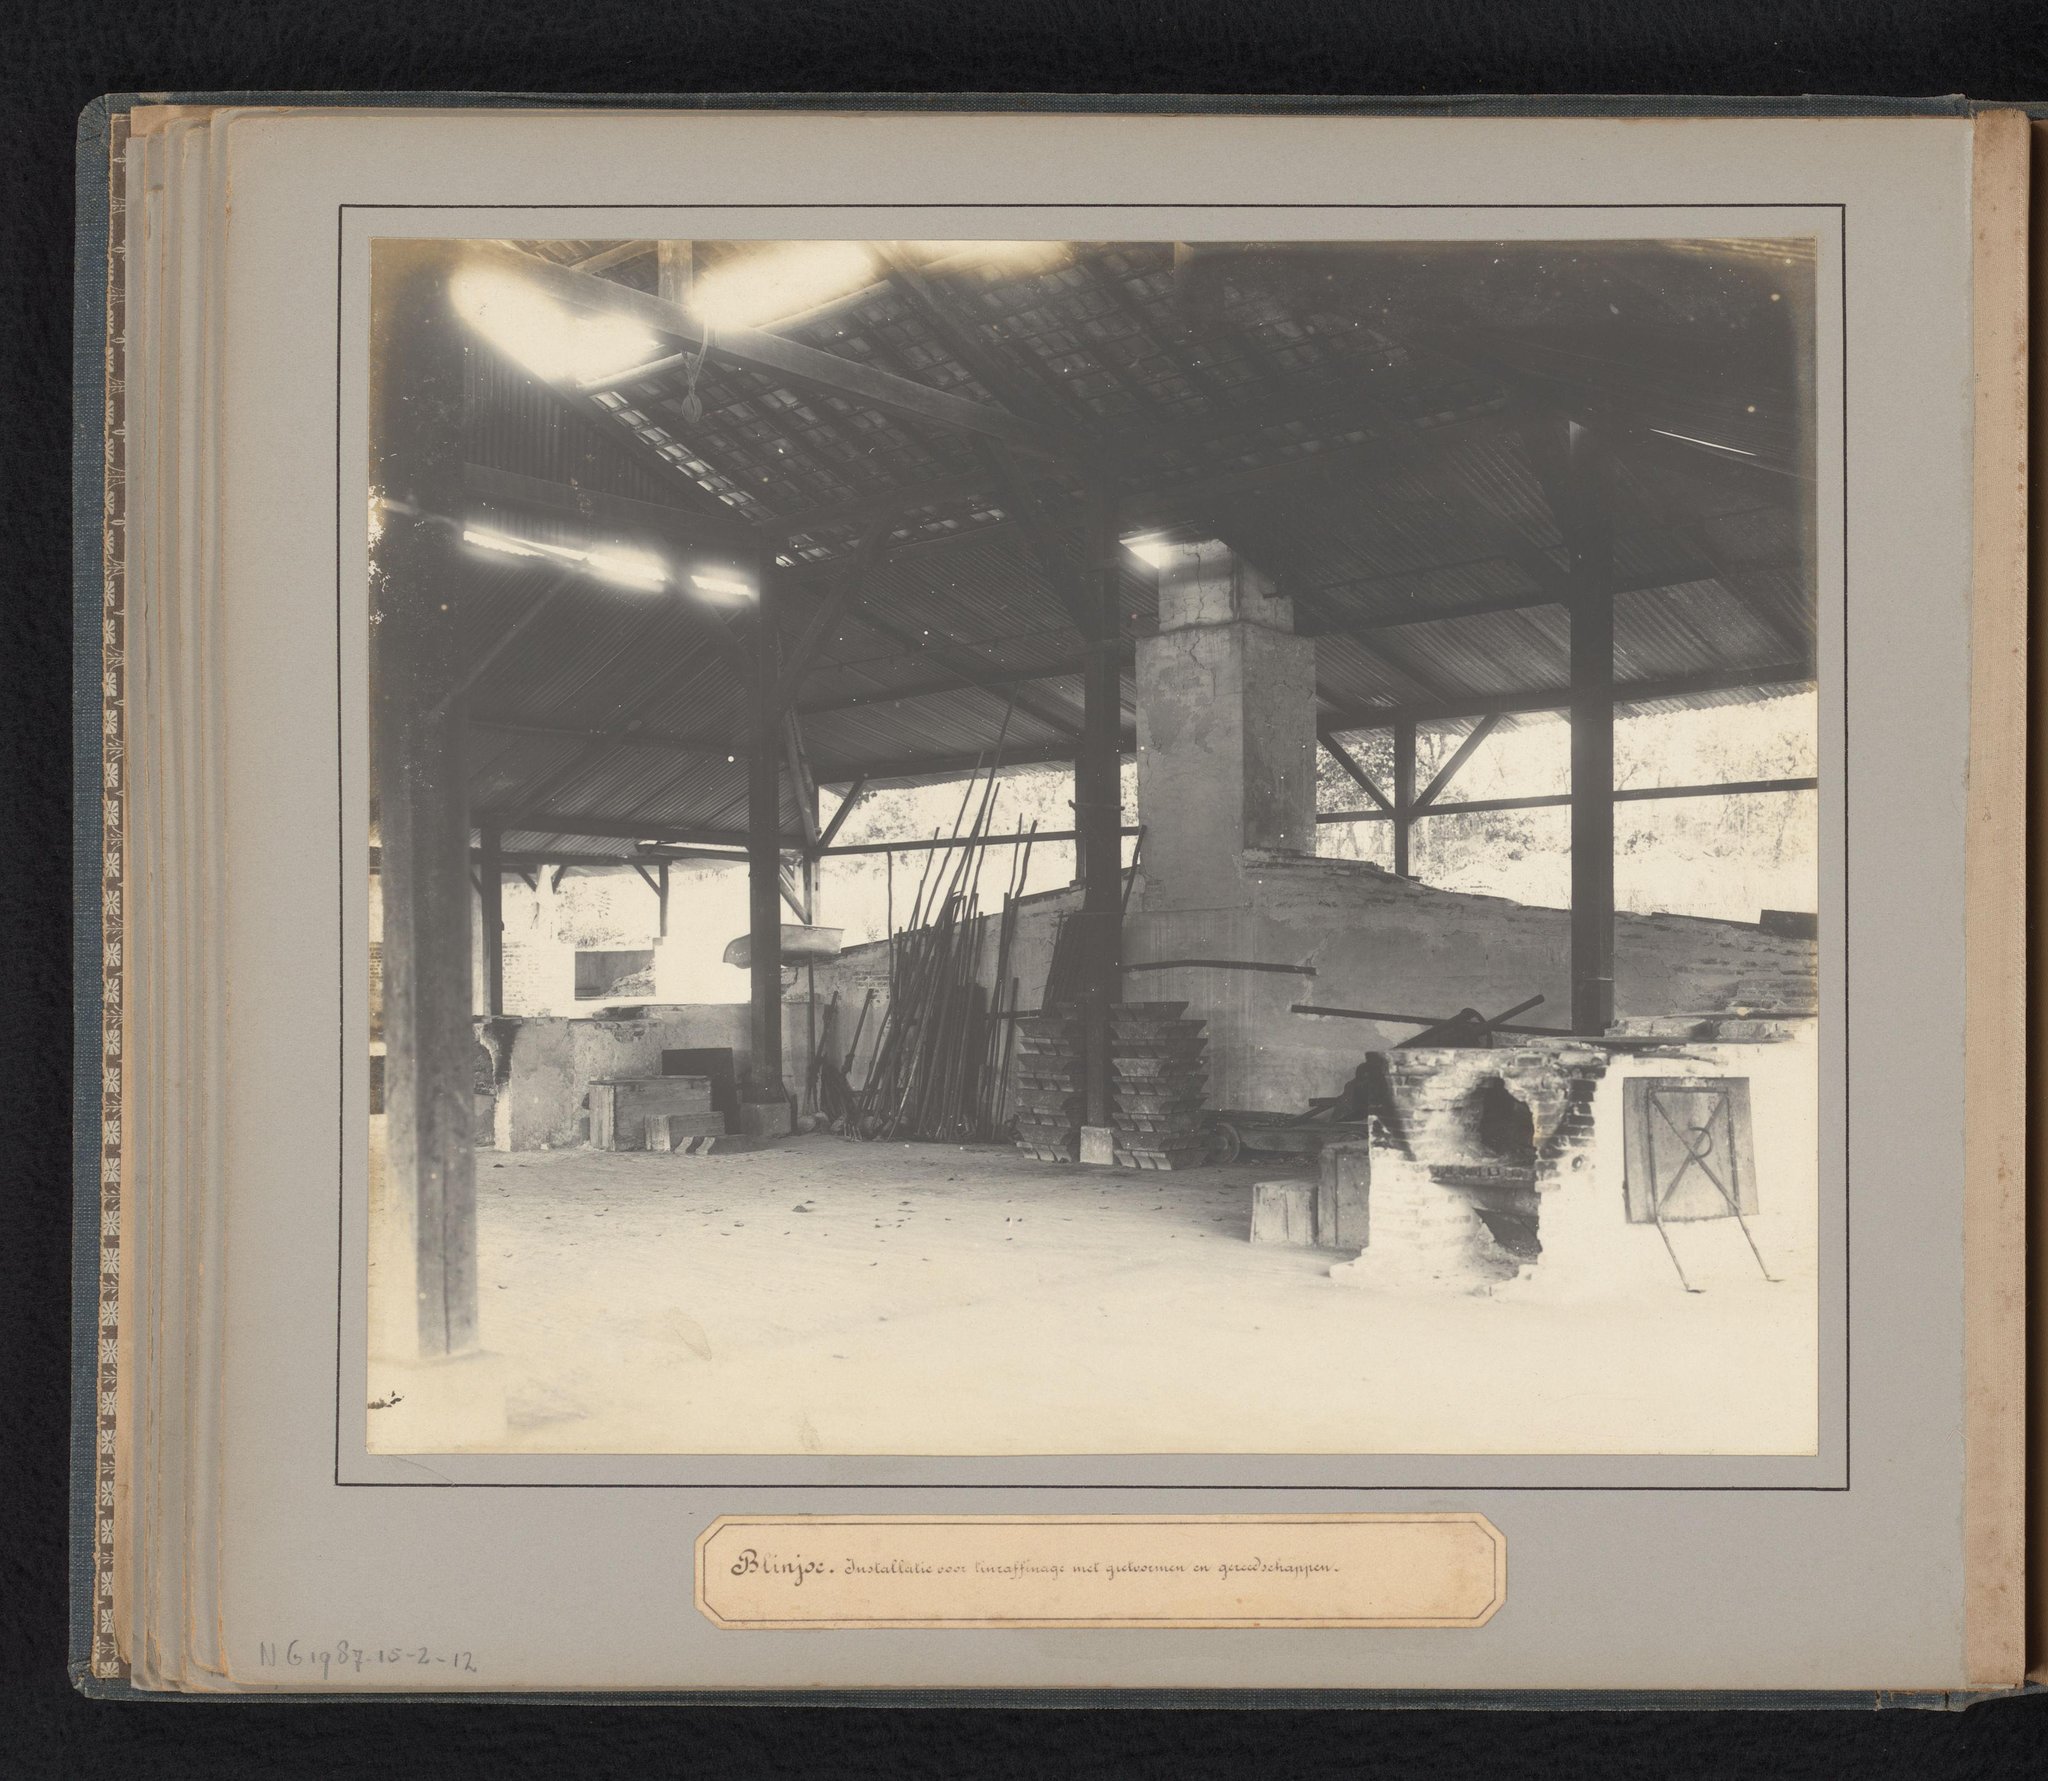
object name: photograph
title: Blinjoe. Installatie voor tinraffinage met gietvormen en gereedschappen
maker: Anonymous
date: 1907-1919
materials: cardboard, photographic support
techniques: gelatin silver print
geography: bangka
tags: robert julius boers, colonial system, factory-interior, machine shop, minerals and metals: tin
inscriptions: label: ‘Blinjoe. Installatie voor tinraffinage met gietvormen en gereedschappen’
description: Loods met een installatie voor de raffinage van tinerts, naast de oven staan opgestapelde gietvormen. In een fabriek van de Banka-tinwinning te Belinyu (Blinjoe). Onderdeel van het fotoalbum over de Banka-tinwinning, ca. 1907-1919.